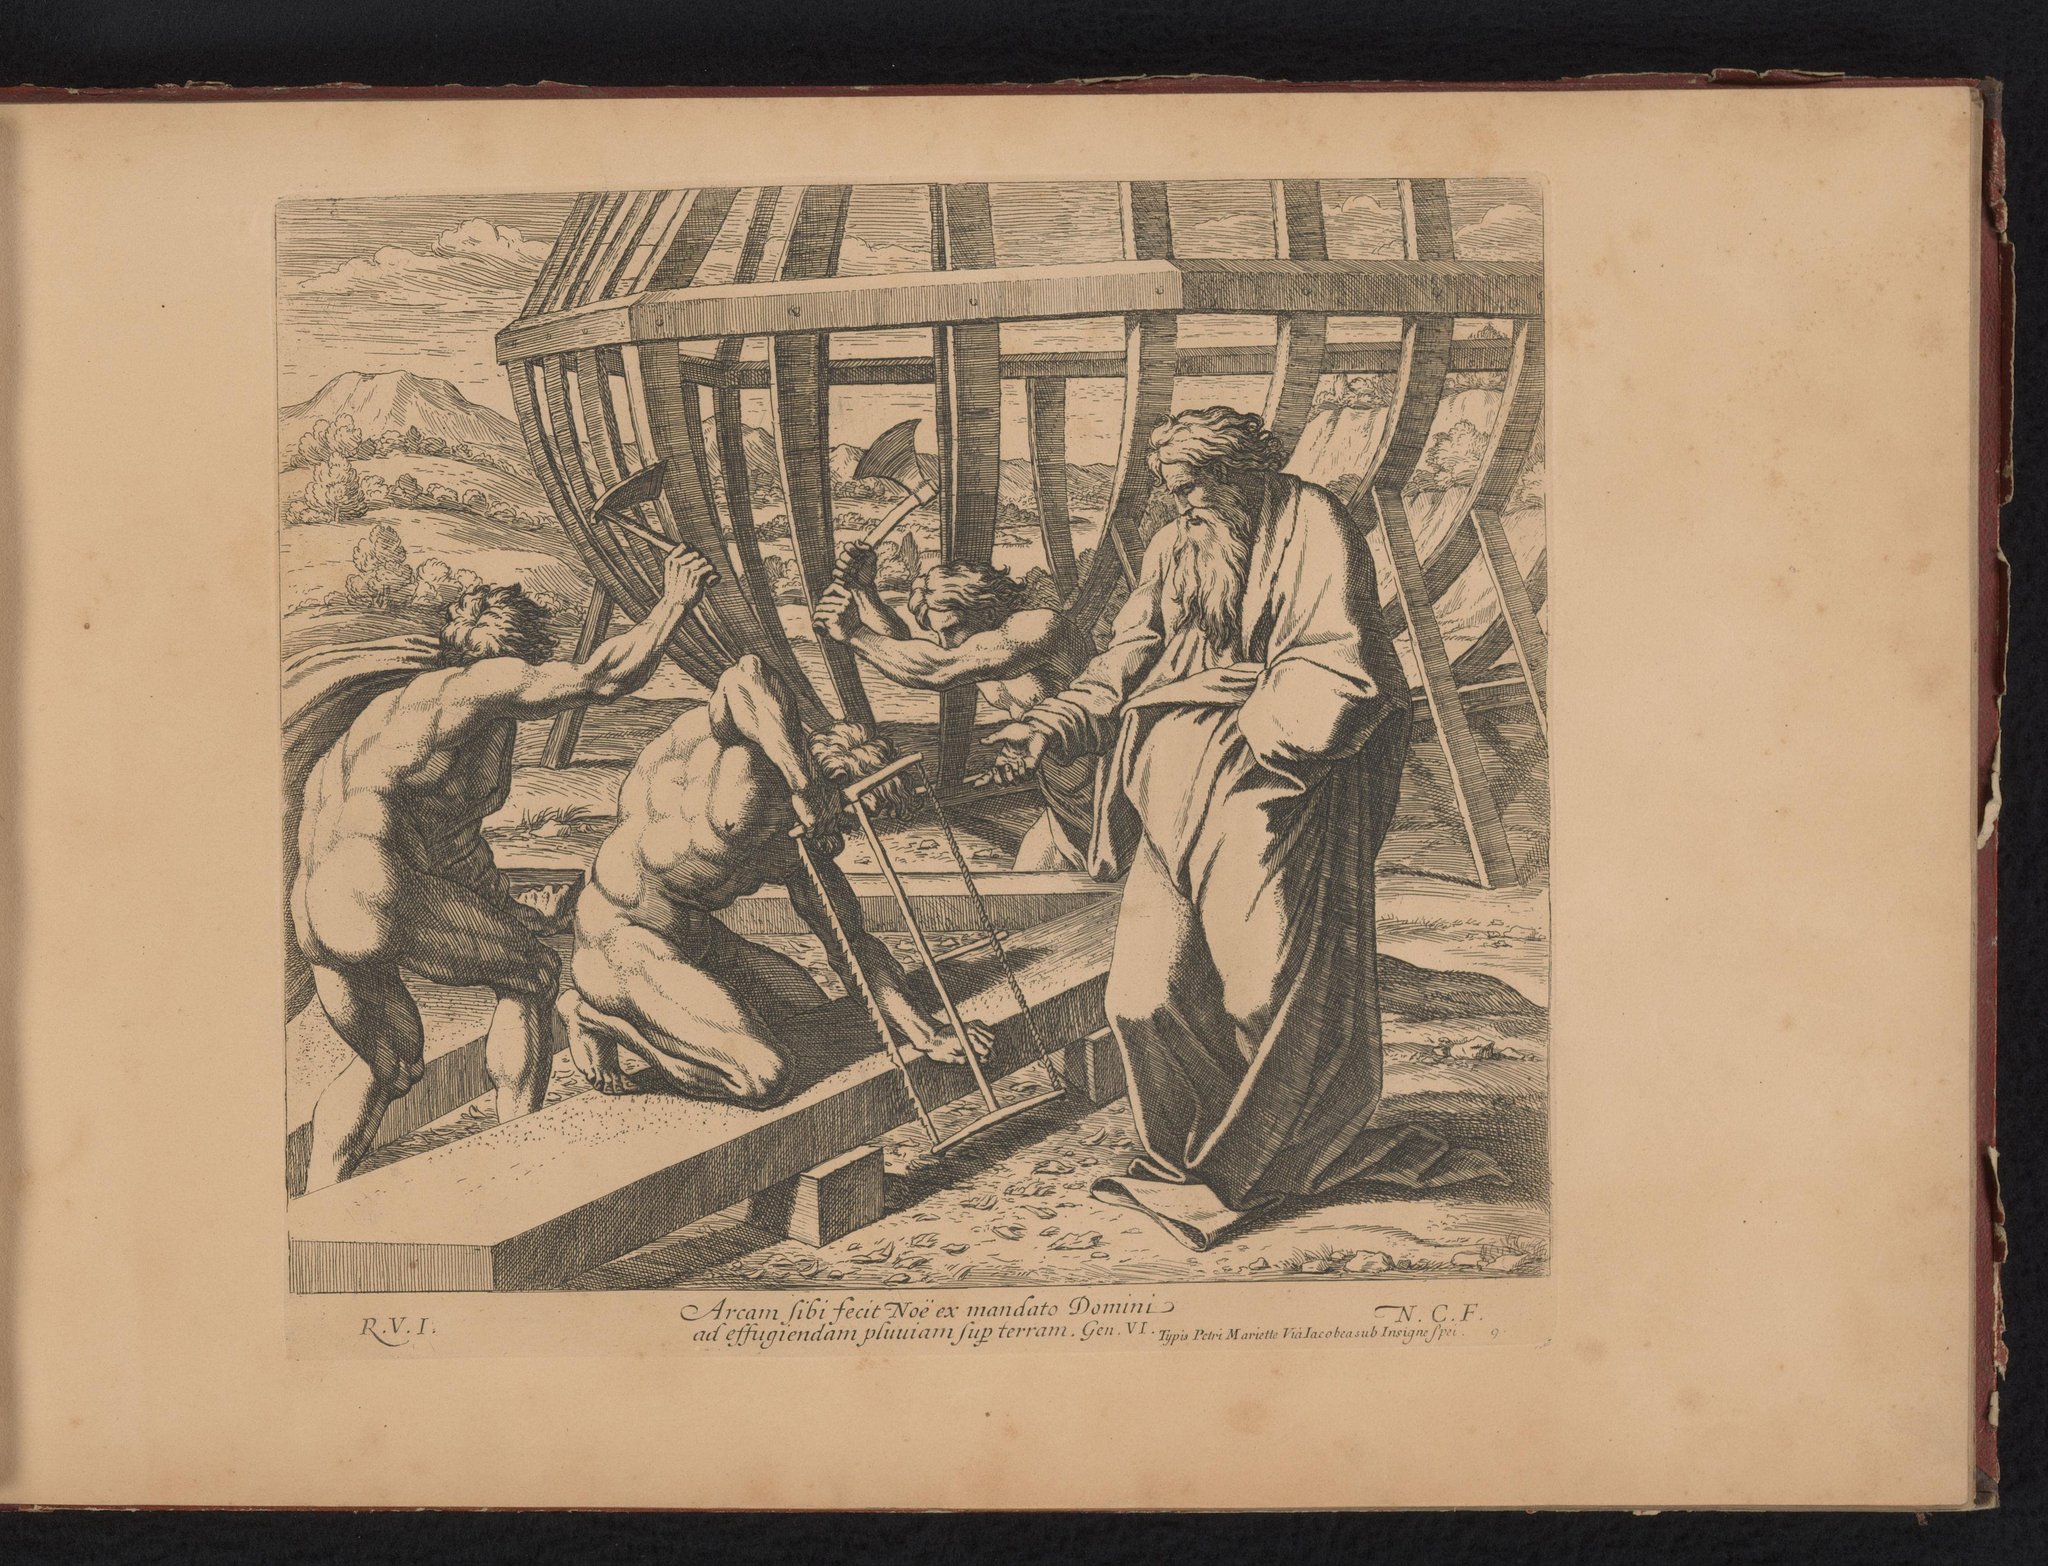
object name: album leaf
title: Rafaël Bijbel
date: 1649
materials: paper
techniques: etching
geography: paris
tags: adam engaged in agricultural activities, eve suckling the children, the labours of adam and eve; infancy of cain and abel (genesis 4:1-2)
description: Deze prent maakt deel uit van een album.